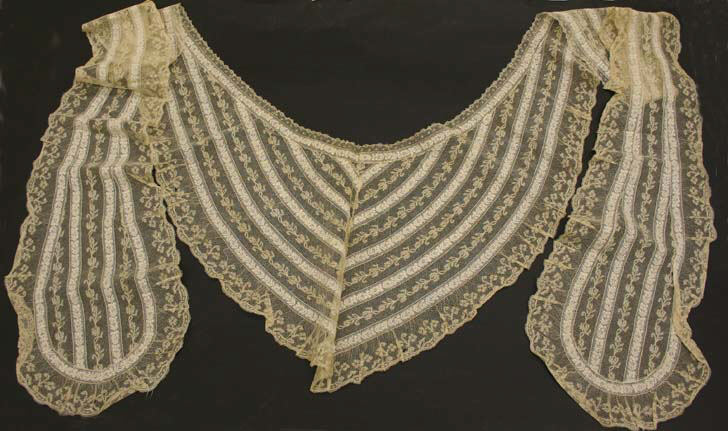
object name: shawl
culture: american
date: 1857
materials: cotton